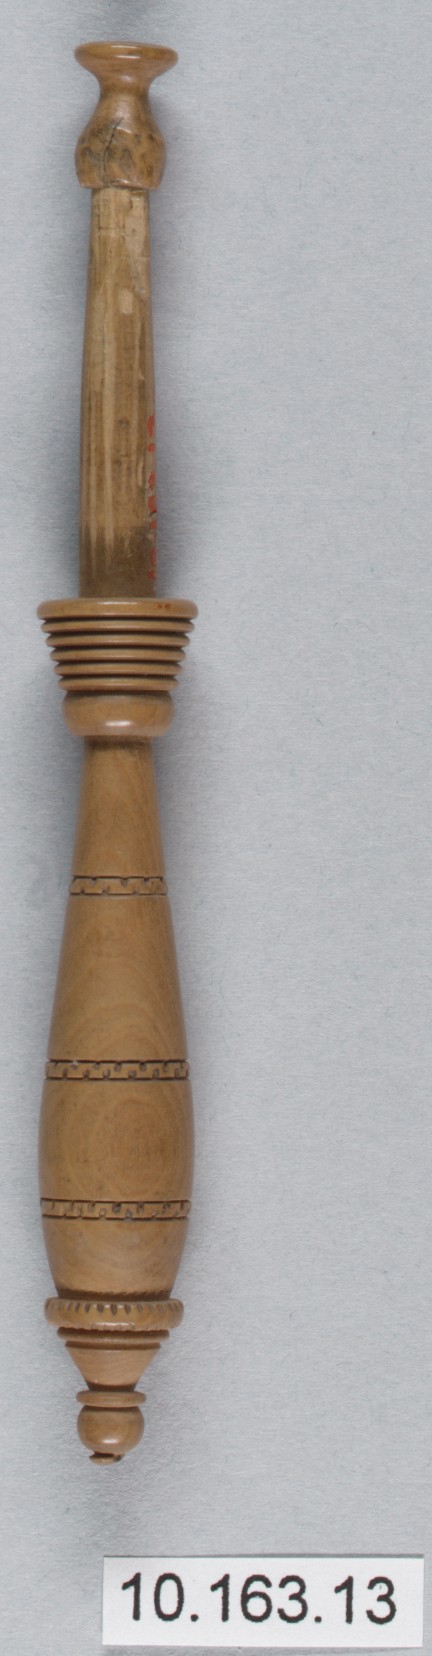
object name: bobbin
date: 1801-1900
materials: wood